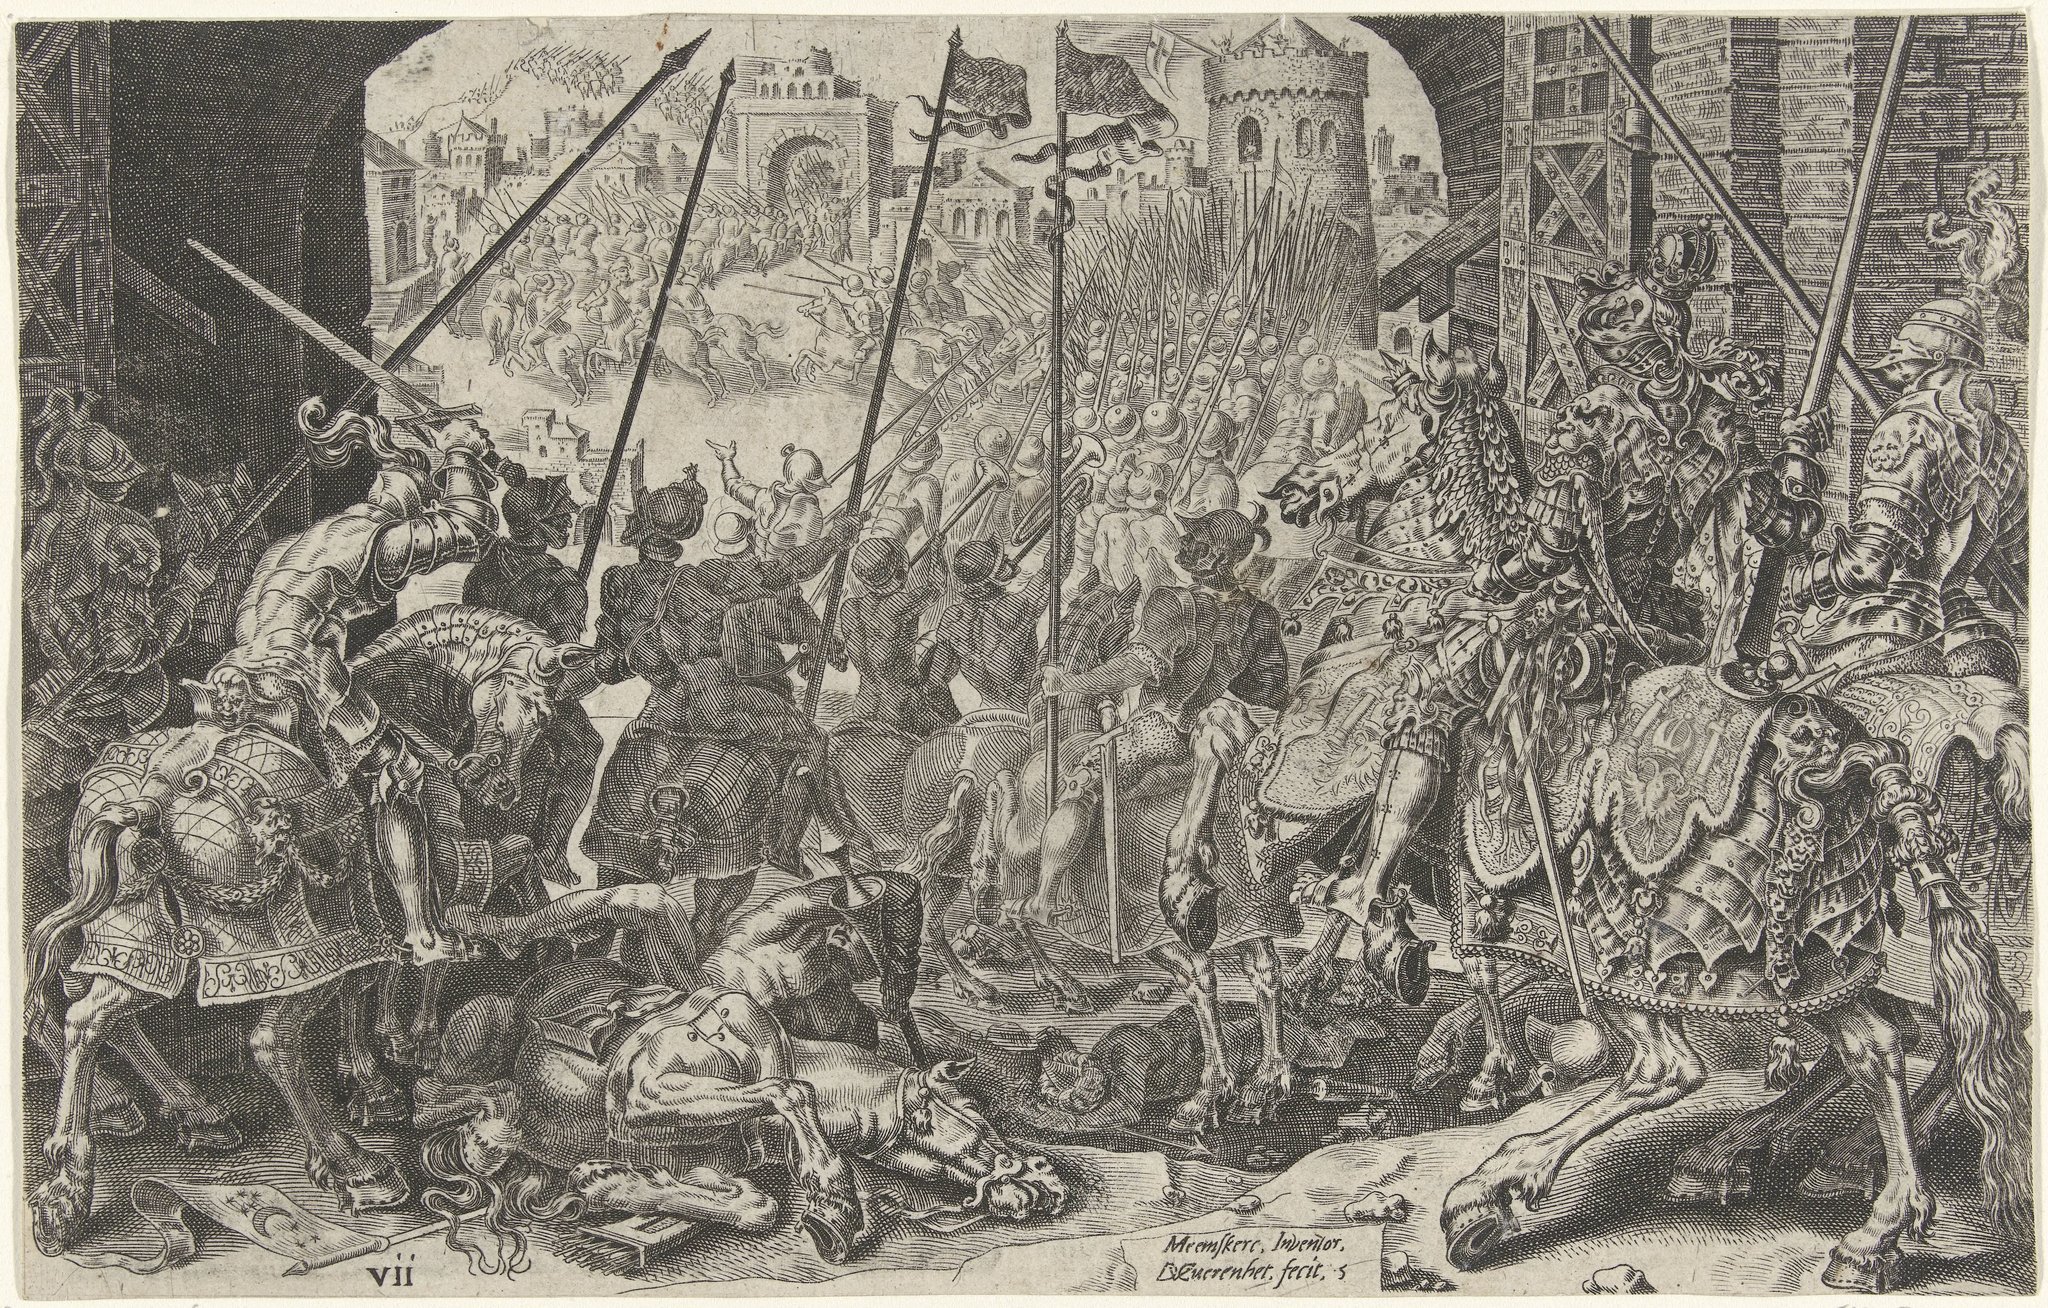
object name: history print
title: Divi Caroli. V. imp. opt. max. victoriae, ex multis praecipuae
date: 1555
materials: paper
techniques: engraving, etching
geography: haarlem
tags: ghent, charles v (holy roman emperor and king of spain)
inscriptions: collector's mark: Lugt 2228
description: Verovering van Tunis (1535). De keizerlijke troepen trekken de stad binnen. Rechts Karel V te paard. De prent maakt deel uit van een twaalfdelige serie over de overwinningen van Karel V.